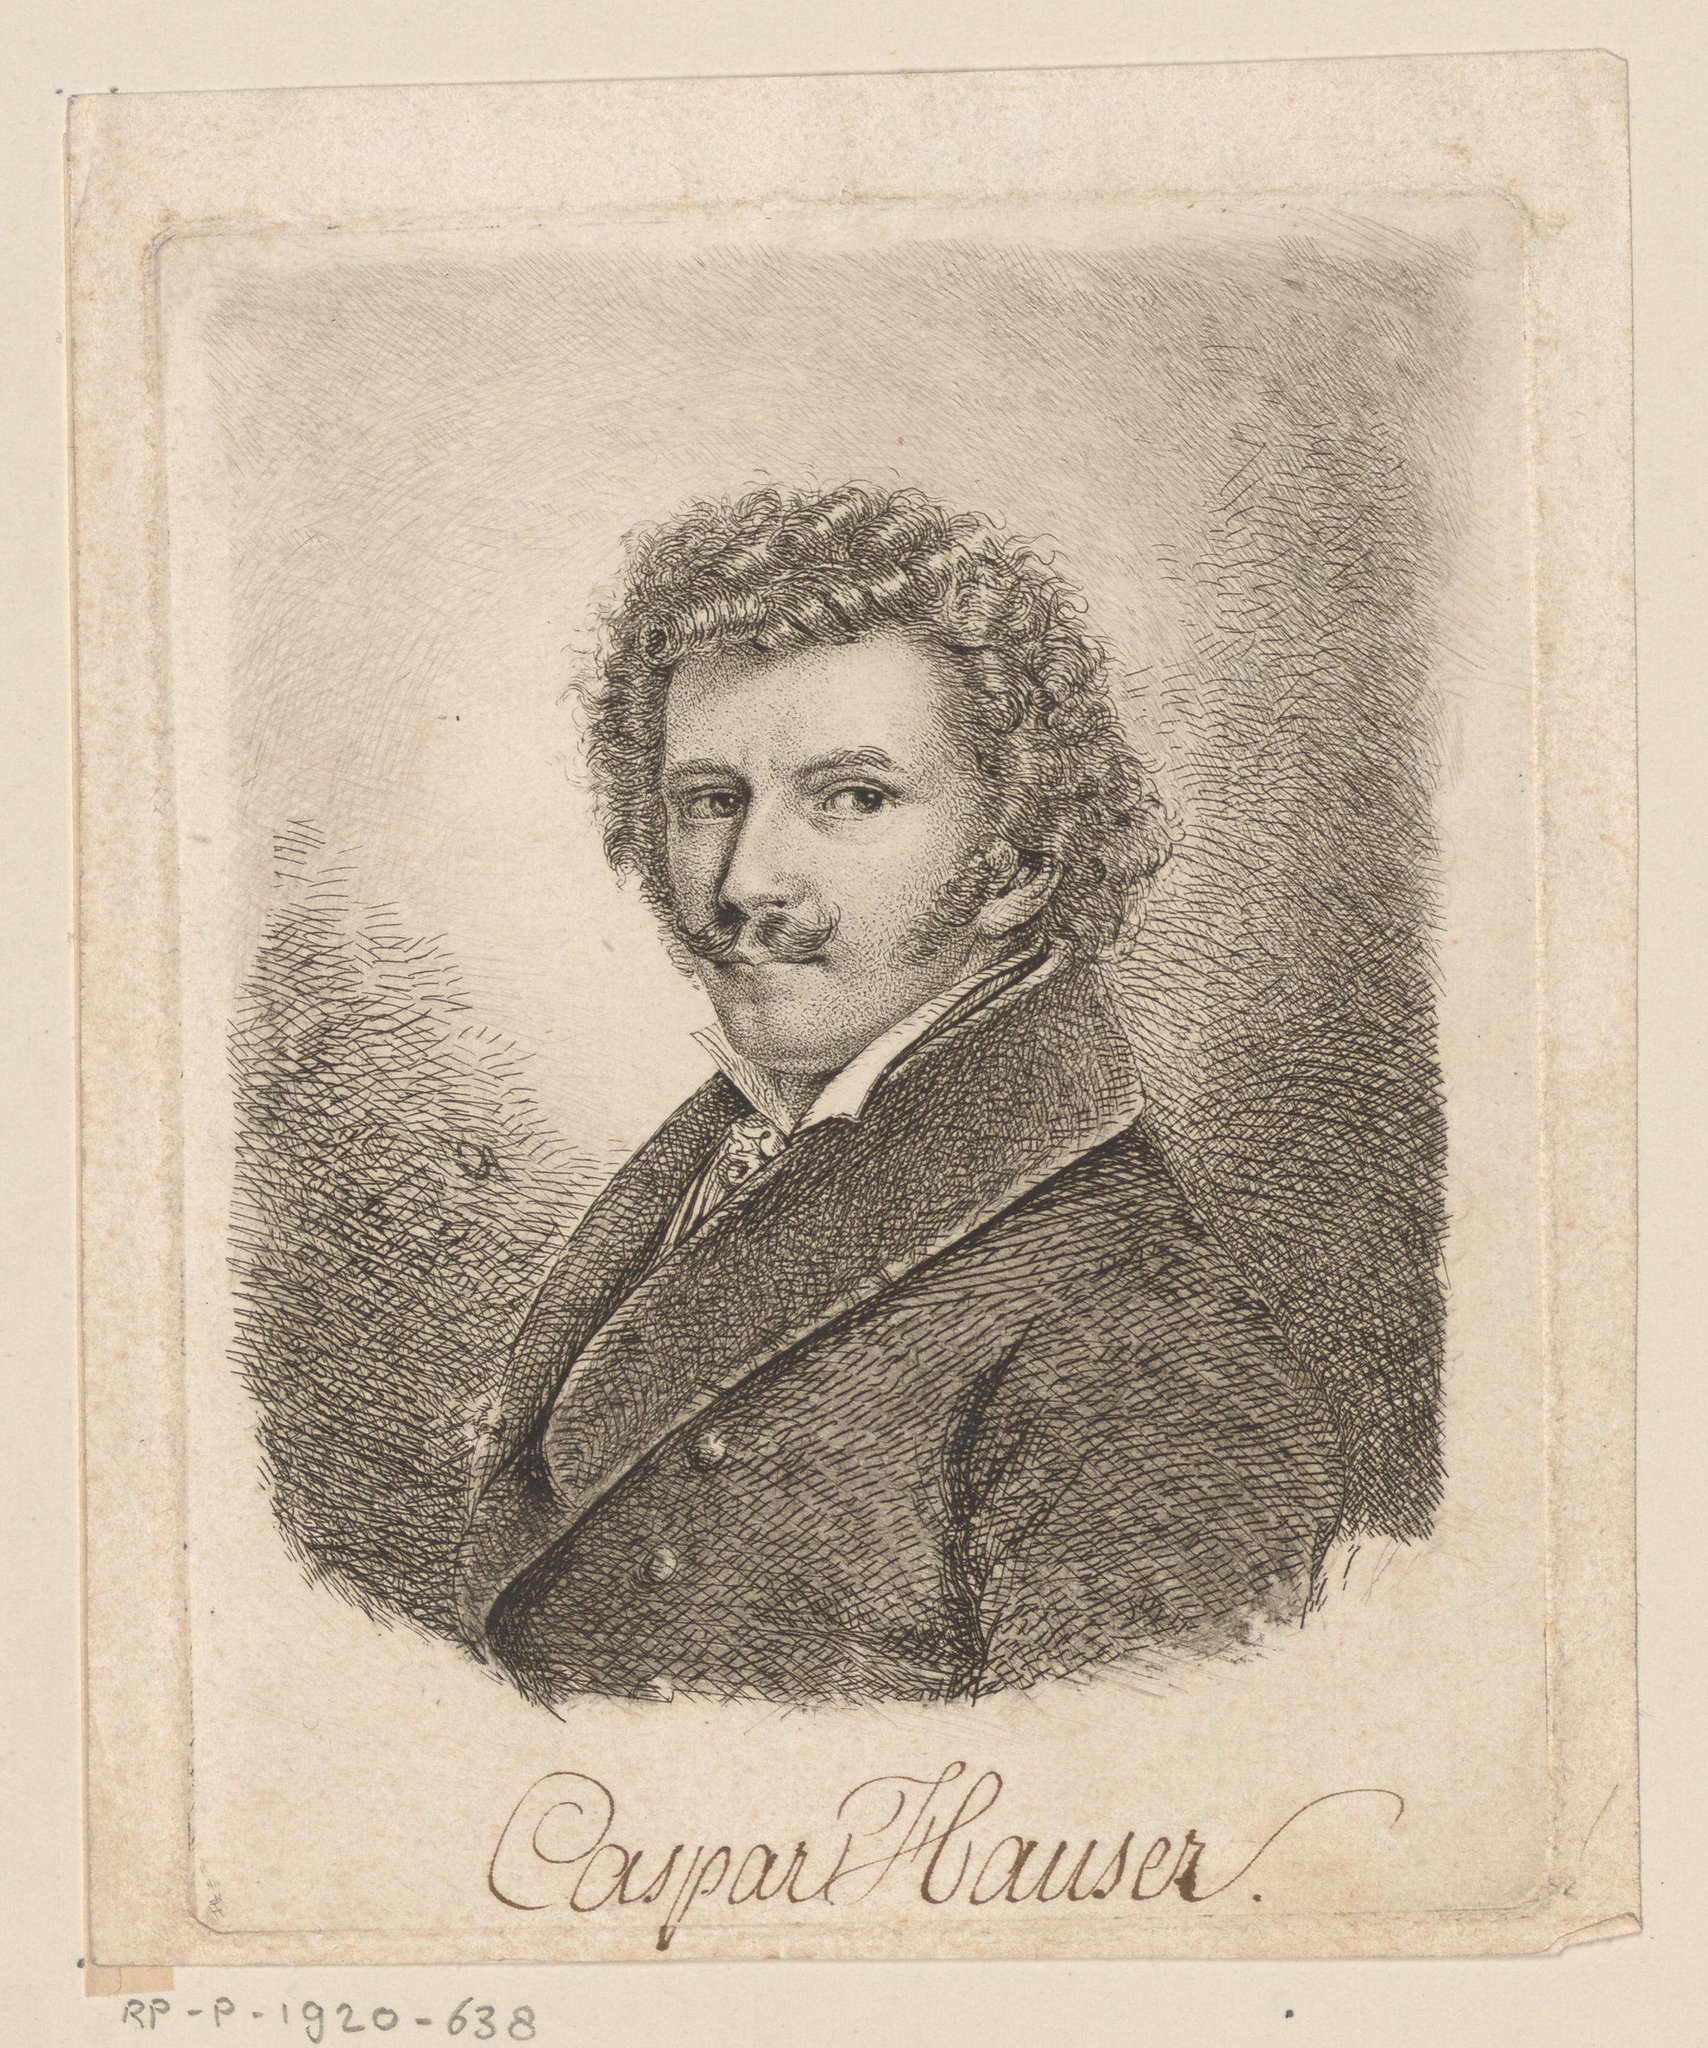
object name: print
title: Portret van een man, aangeduid als Caspar Hauser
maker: Anonymous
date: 1800-1849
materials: paper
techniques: drypoint, etching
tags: historical persons not known by name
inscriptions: collector's mark: Lugt 2228, inscription: ‘Caspar Hauser’